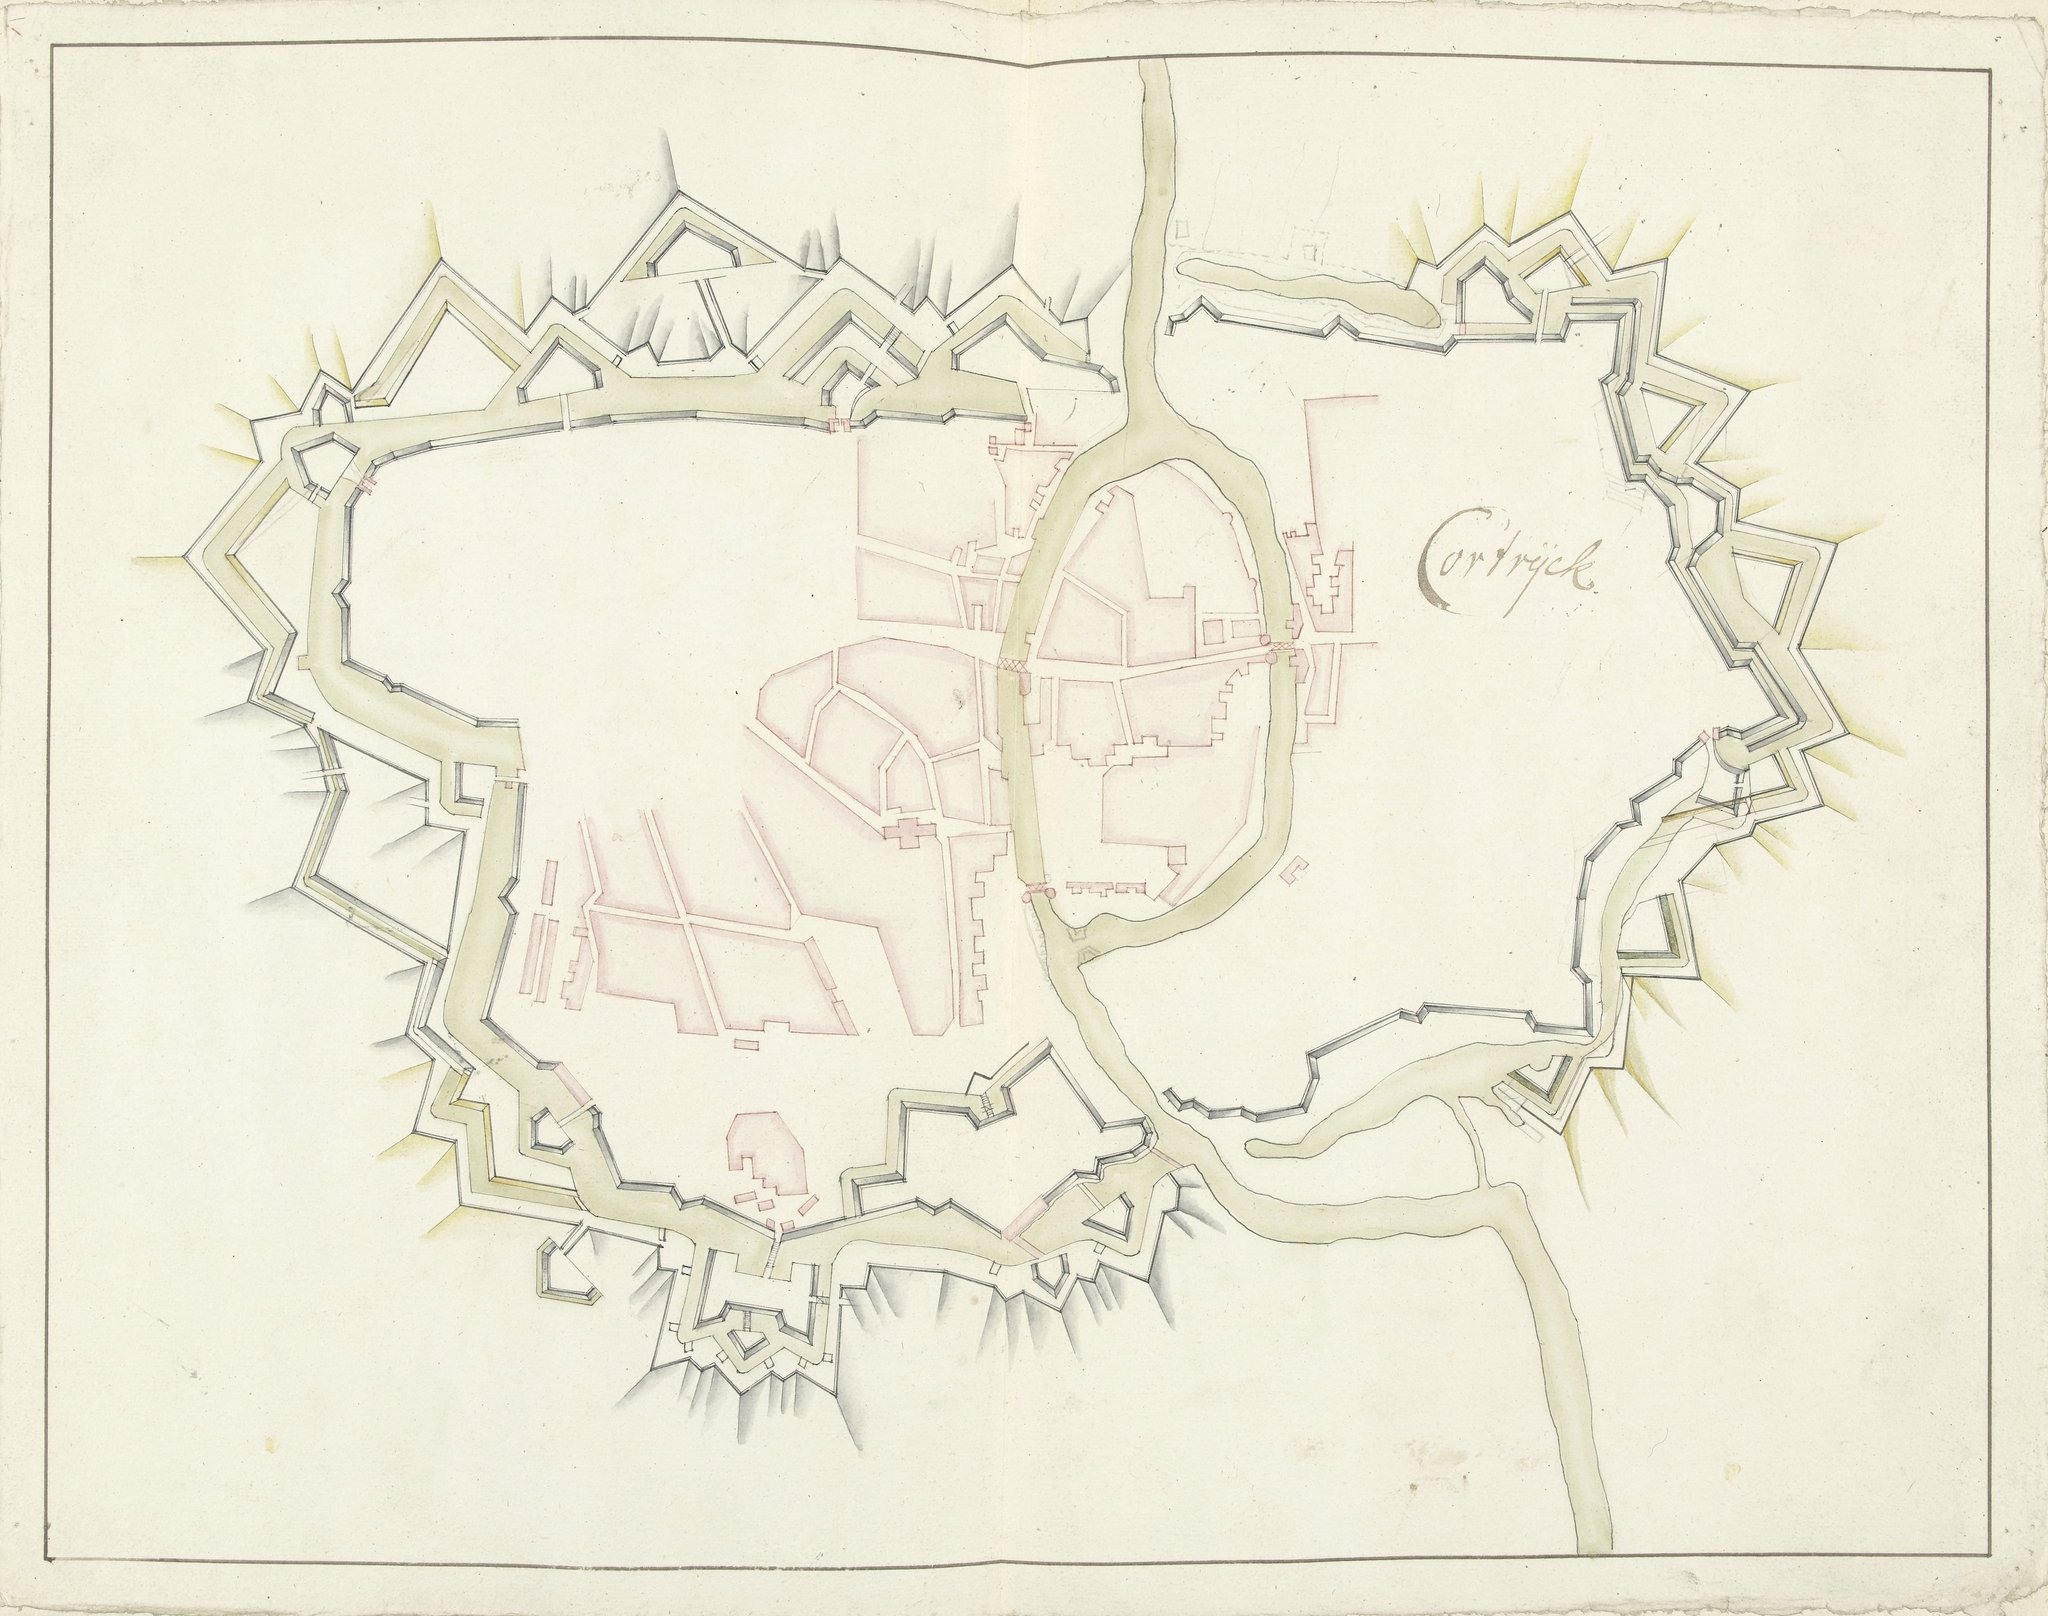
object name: drawing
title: Plattegrond van Kortrijk, ca. 1701-1715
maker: samuel du ry de champdoré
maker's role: draughtsman, engineer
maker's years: 1651-1729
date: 1701-1715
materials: paper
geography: netherlands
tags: fortress, maps of cities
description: Plattegrond van de versterkingen om de stad Kortrijk, ca. 1701-1715. Onderdeel van een verzameling getekende plannen van versterkte plaatsen in Nederland en omringende landen ten tijde van de Spaanse Successieoorlog (deel C).